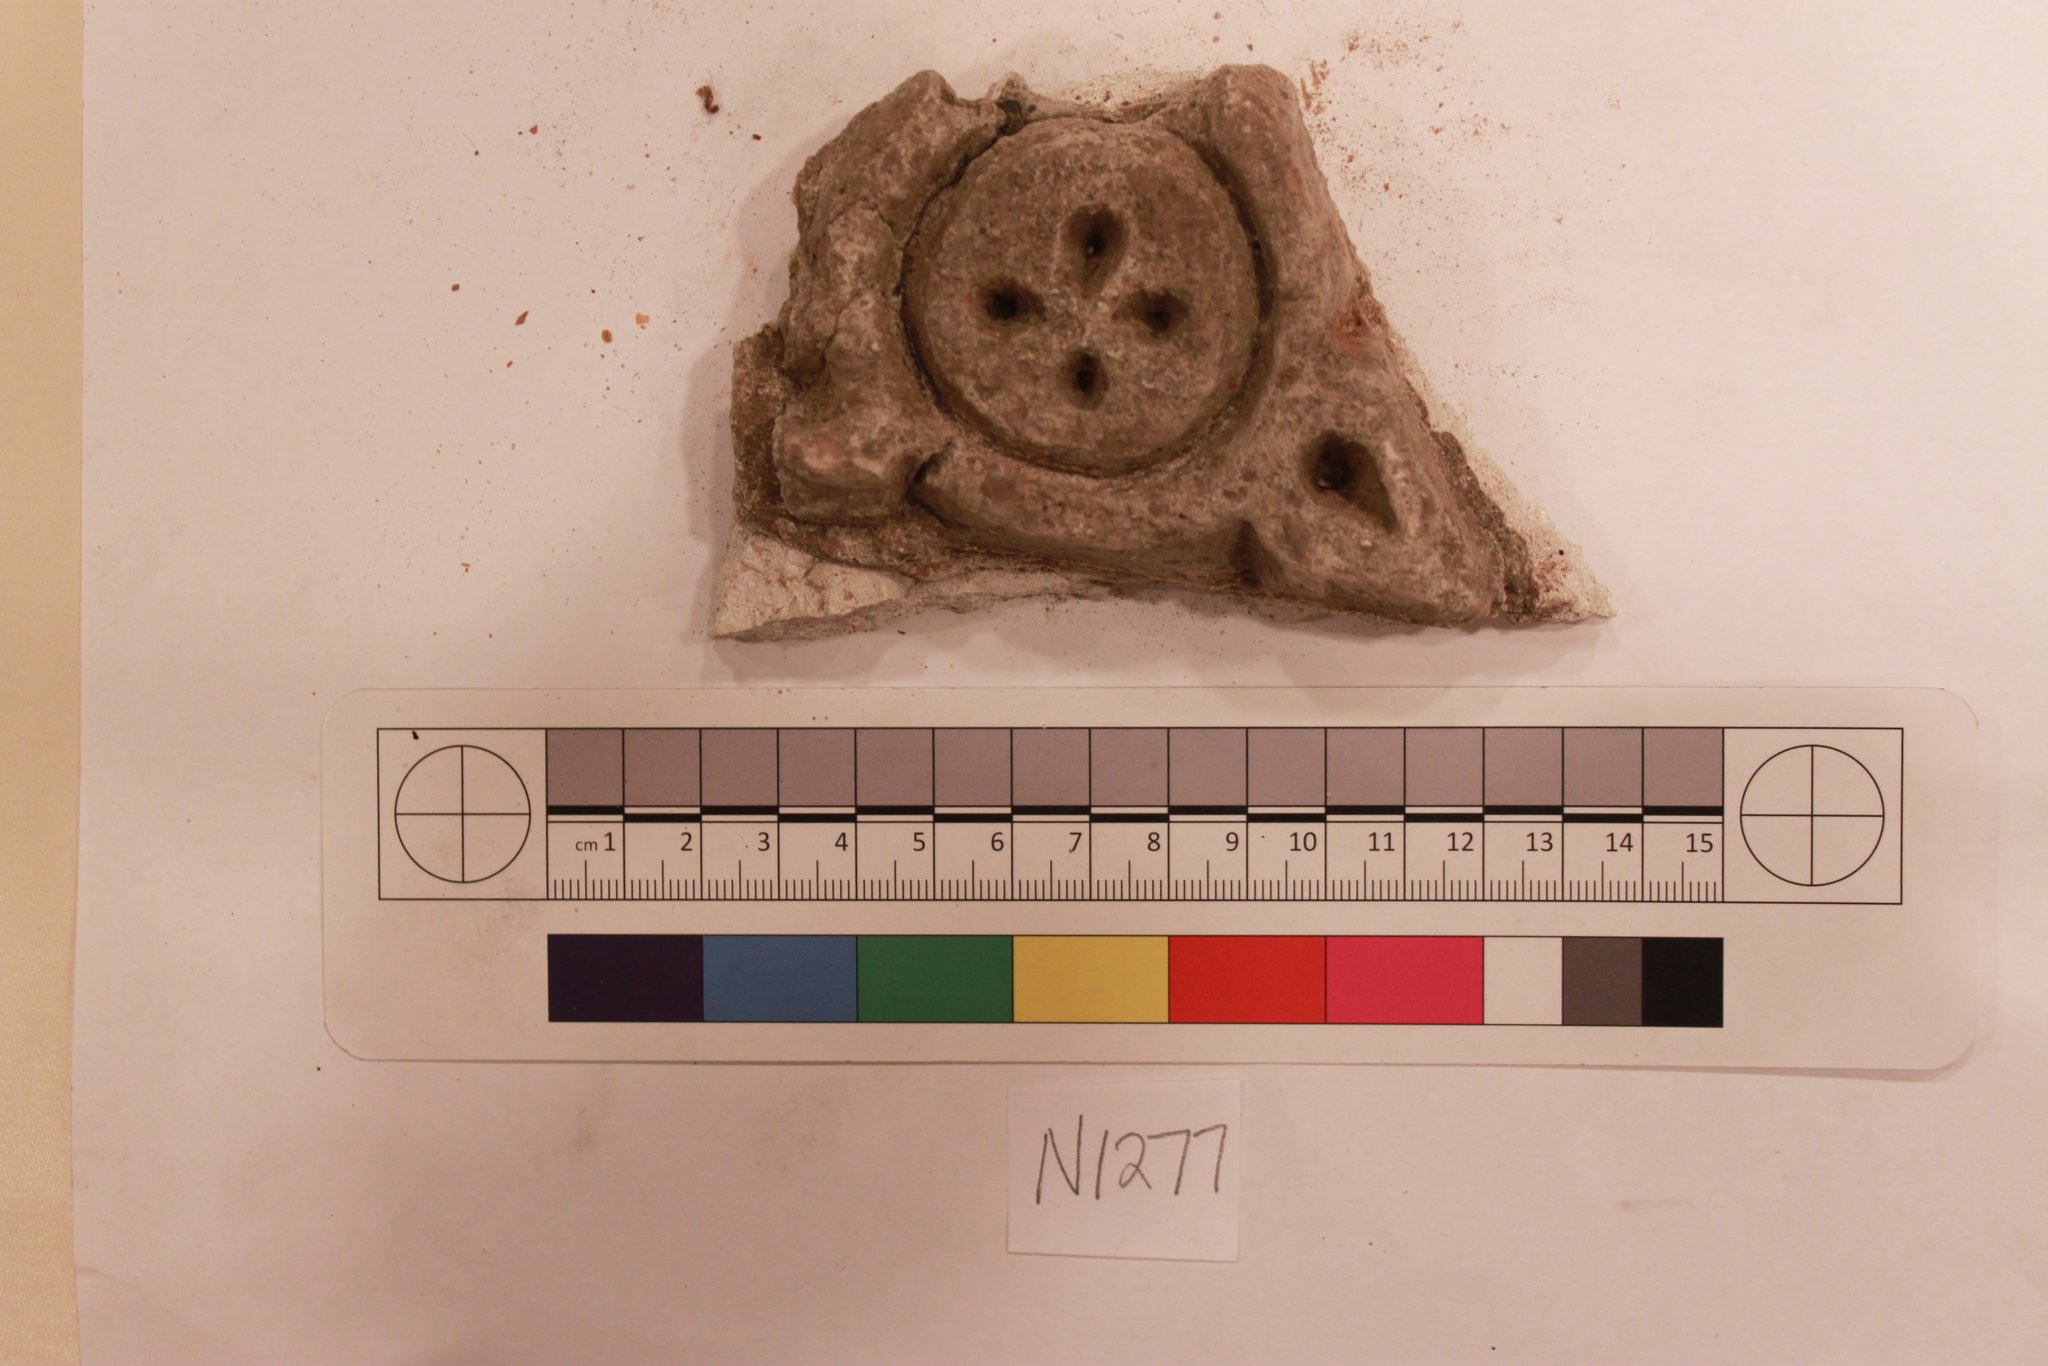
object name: fragment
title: Stucco Fragment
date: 701-1200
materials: plaster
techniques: carving, painting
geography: iran